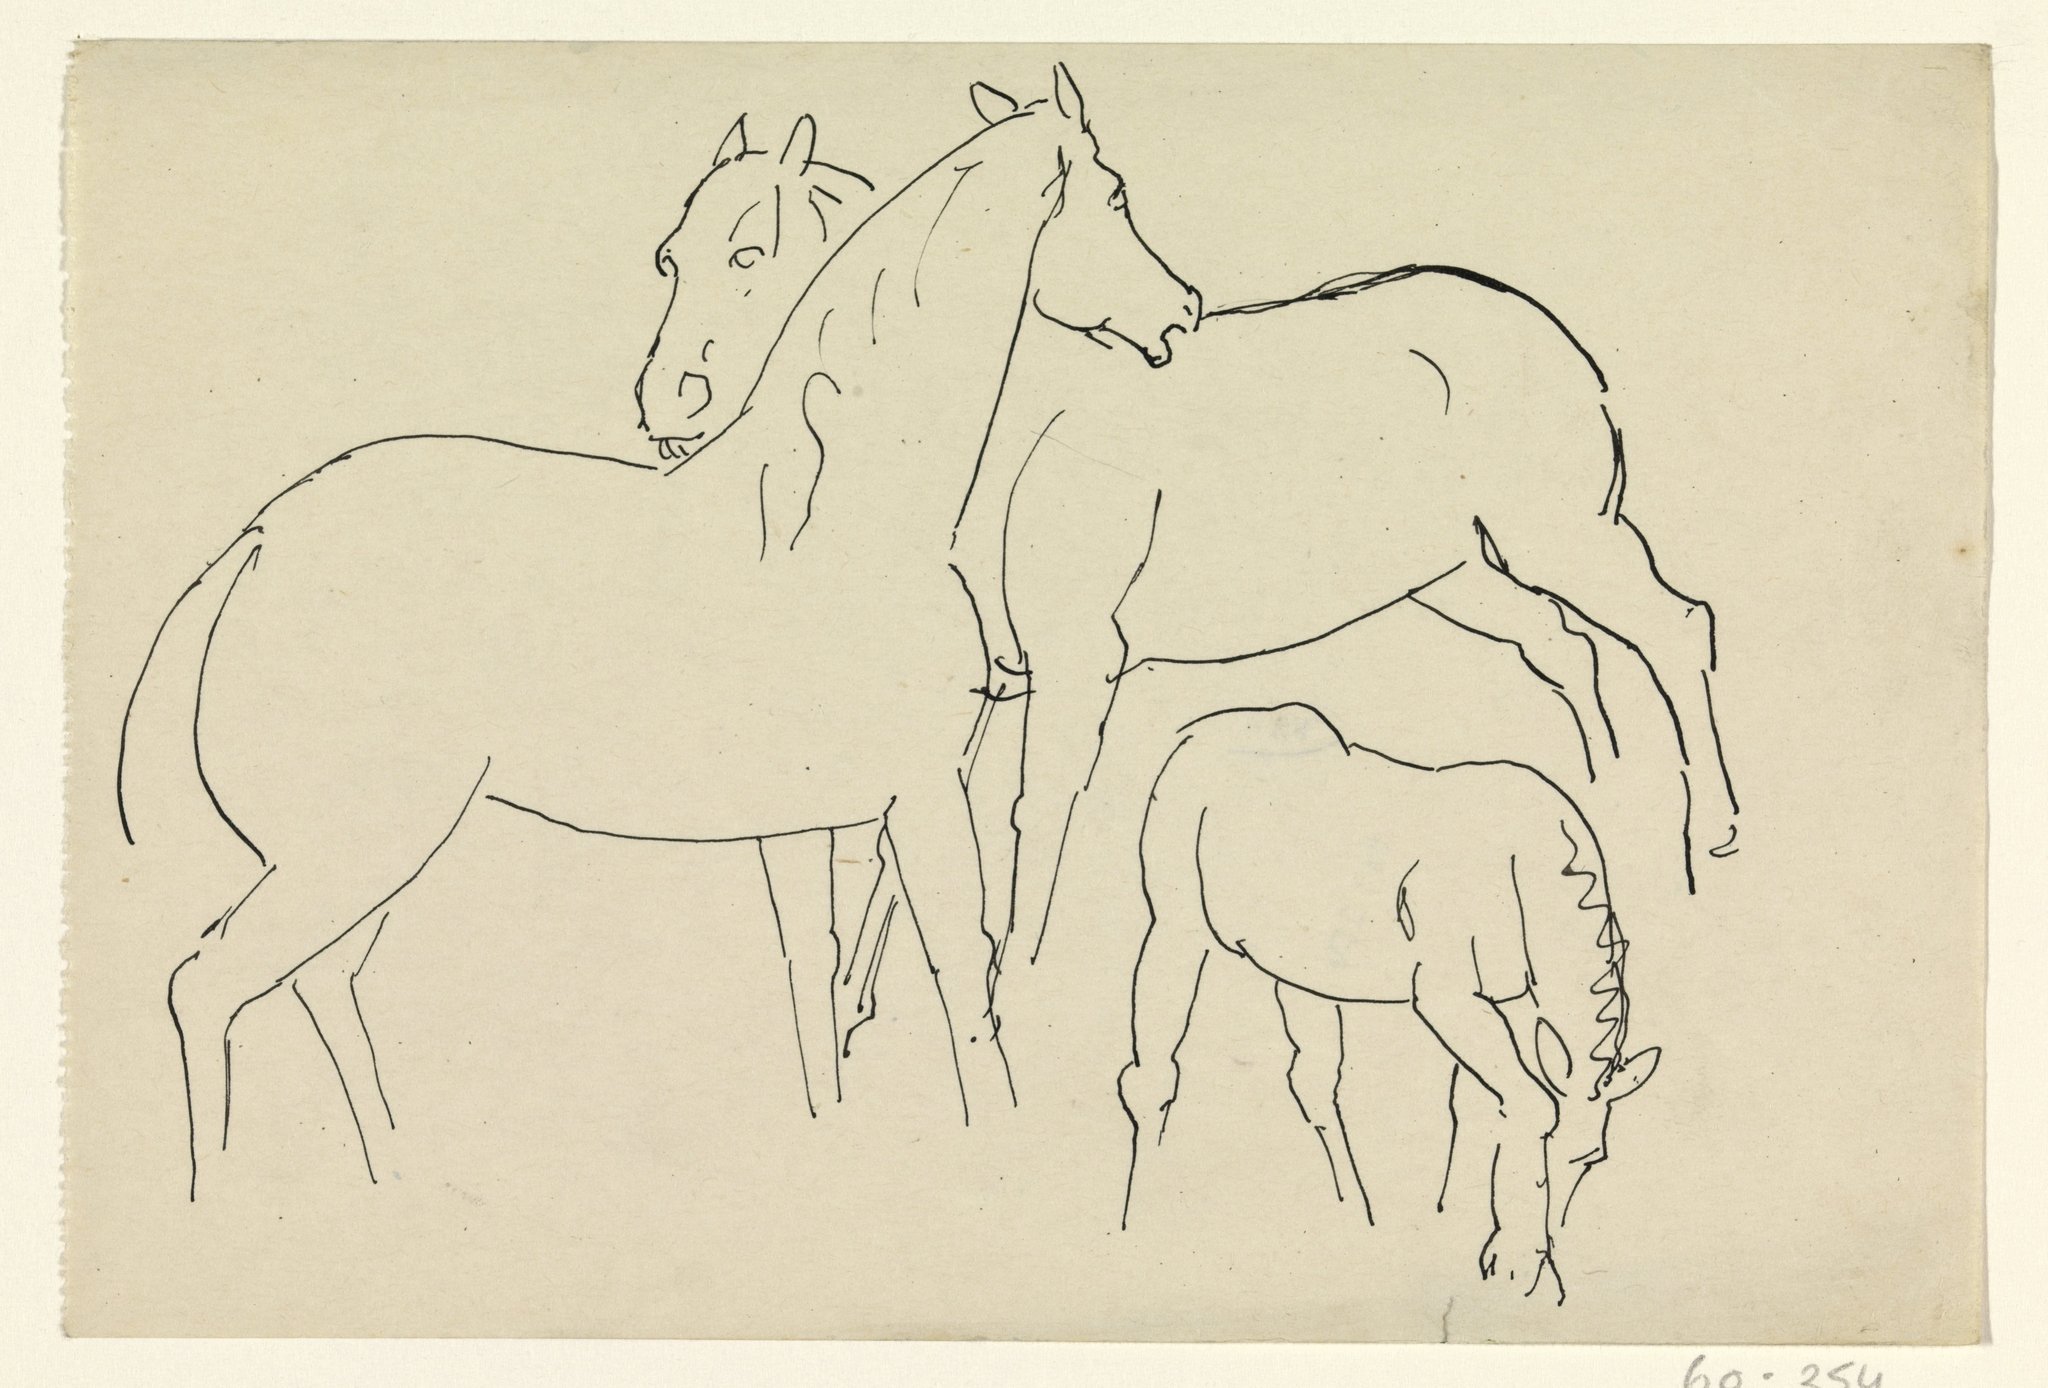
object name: drawing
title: Twee paarden en een veulen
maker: leo gestel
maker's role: draughtsman, print maker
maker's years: 1881-1941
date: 1926-1928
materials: ink, paper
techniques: pen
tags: horse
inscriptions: collector's mark: Lugt 2228